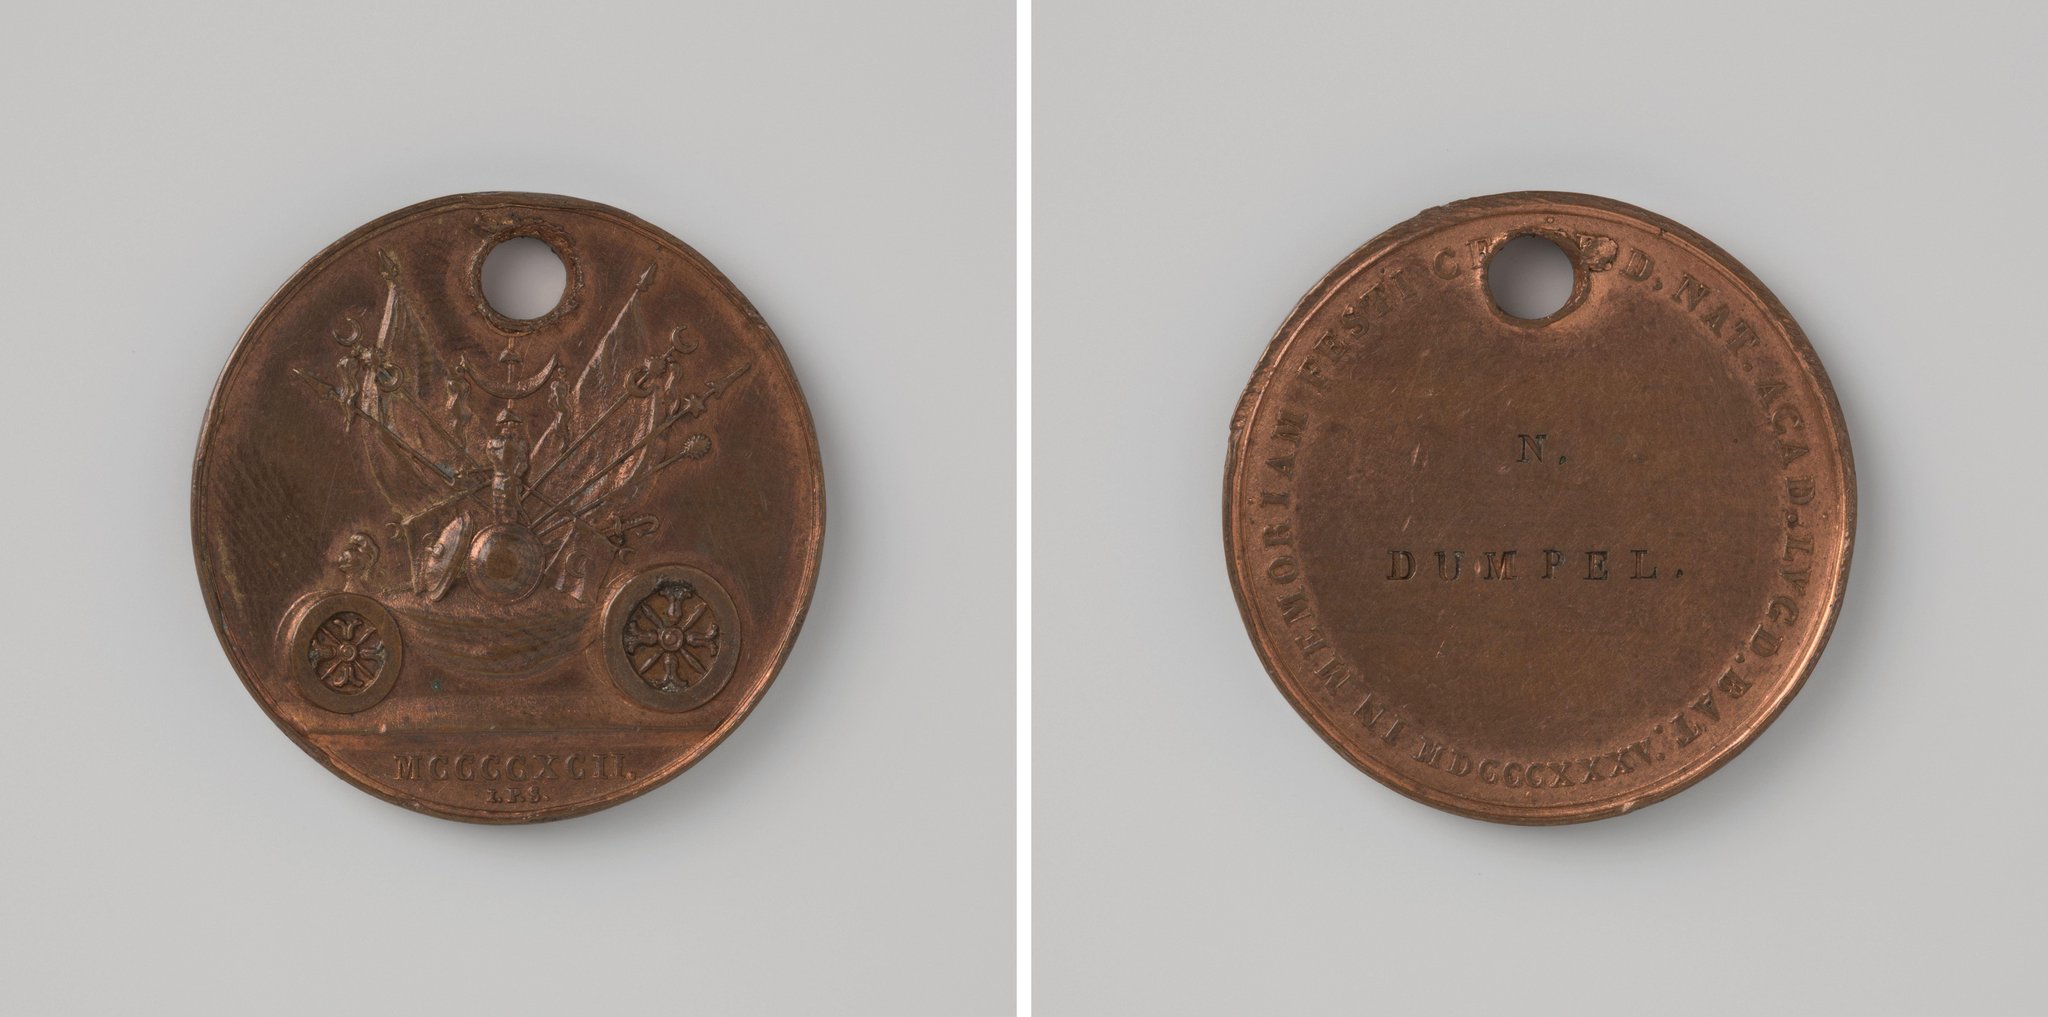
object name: history medal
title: Lustrumfeest van de Leidse Universiteit 1835, op naam van N. Dumpel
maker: johannis petrus schouberg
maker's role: die cutter, draughtsman, print maker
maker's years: 1798-1864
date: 1835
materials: copper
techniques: striking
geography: utrecht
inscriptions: inscription: ‘N. / DUMPEL.’, signature: ‘I. P. S.’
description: Koperen penning, op de voorzijde een triomfwagen met militaire trofee, het jaartal in de afsnede, op de keerzijde een inscriptieruimte binnnen een omschrift, met doorboring